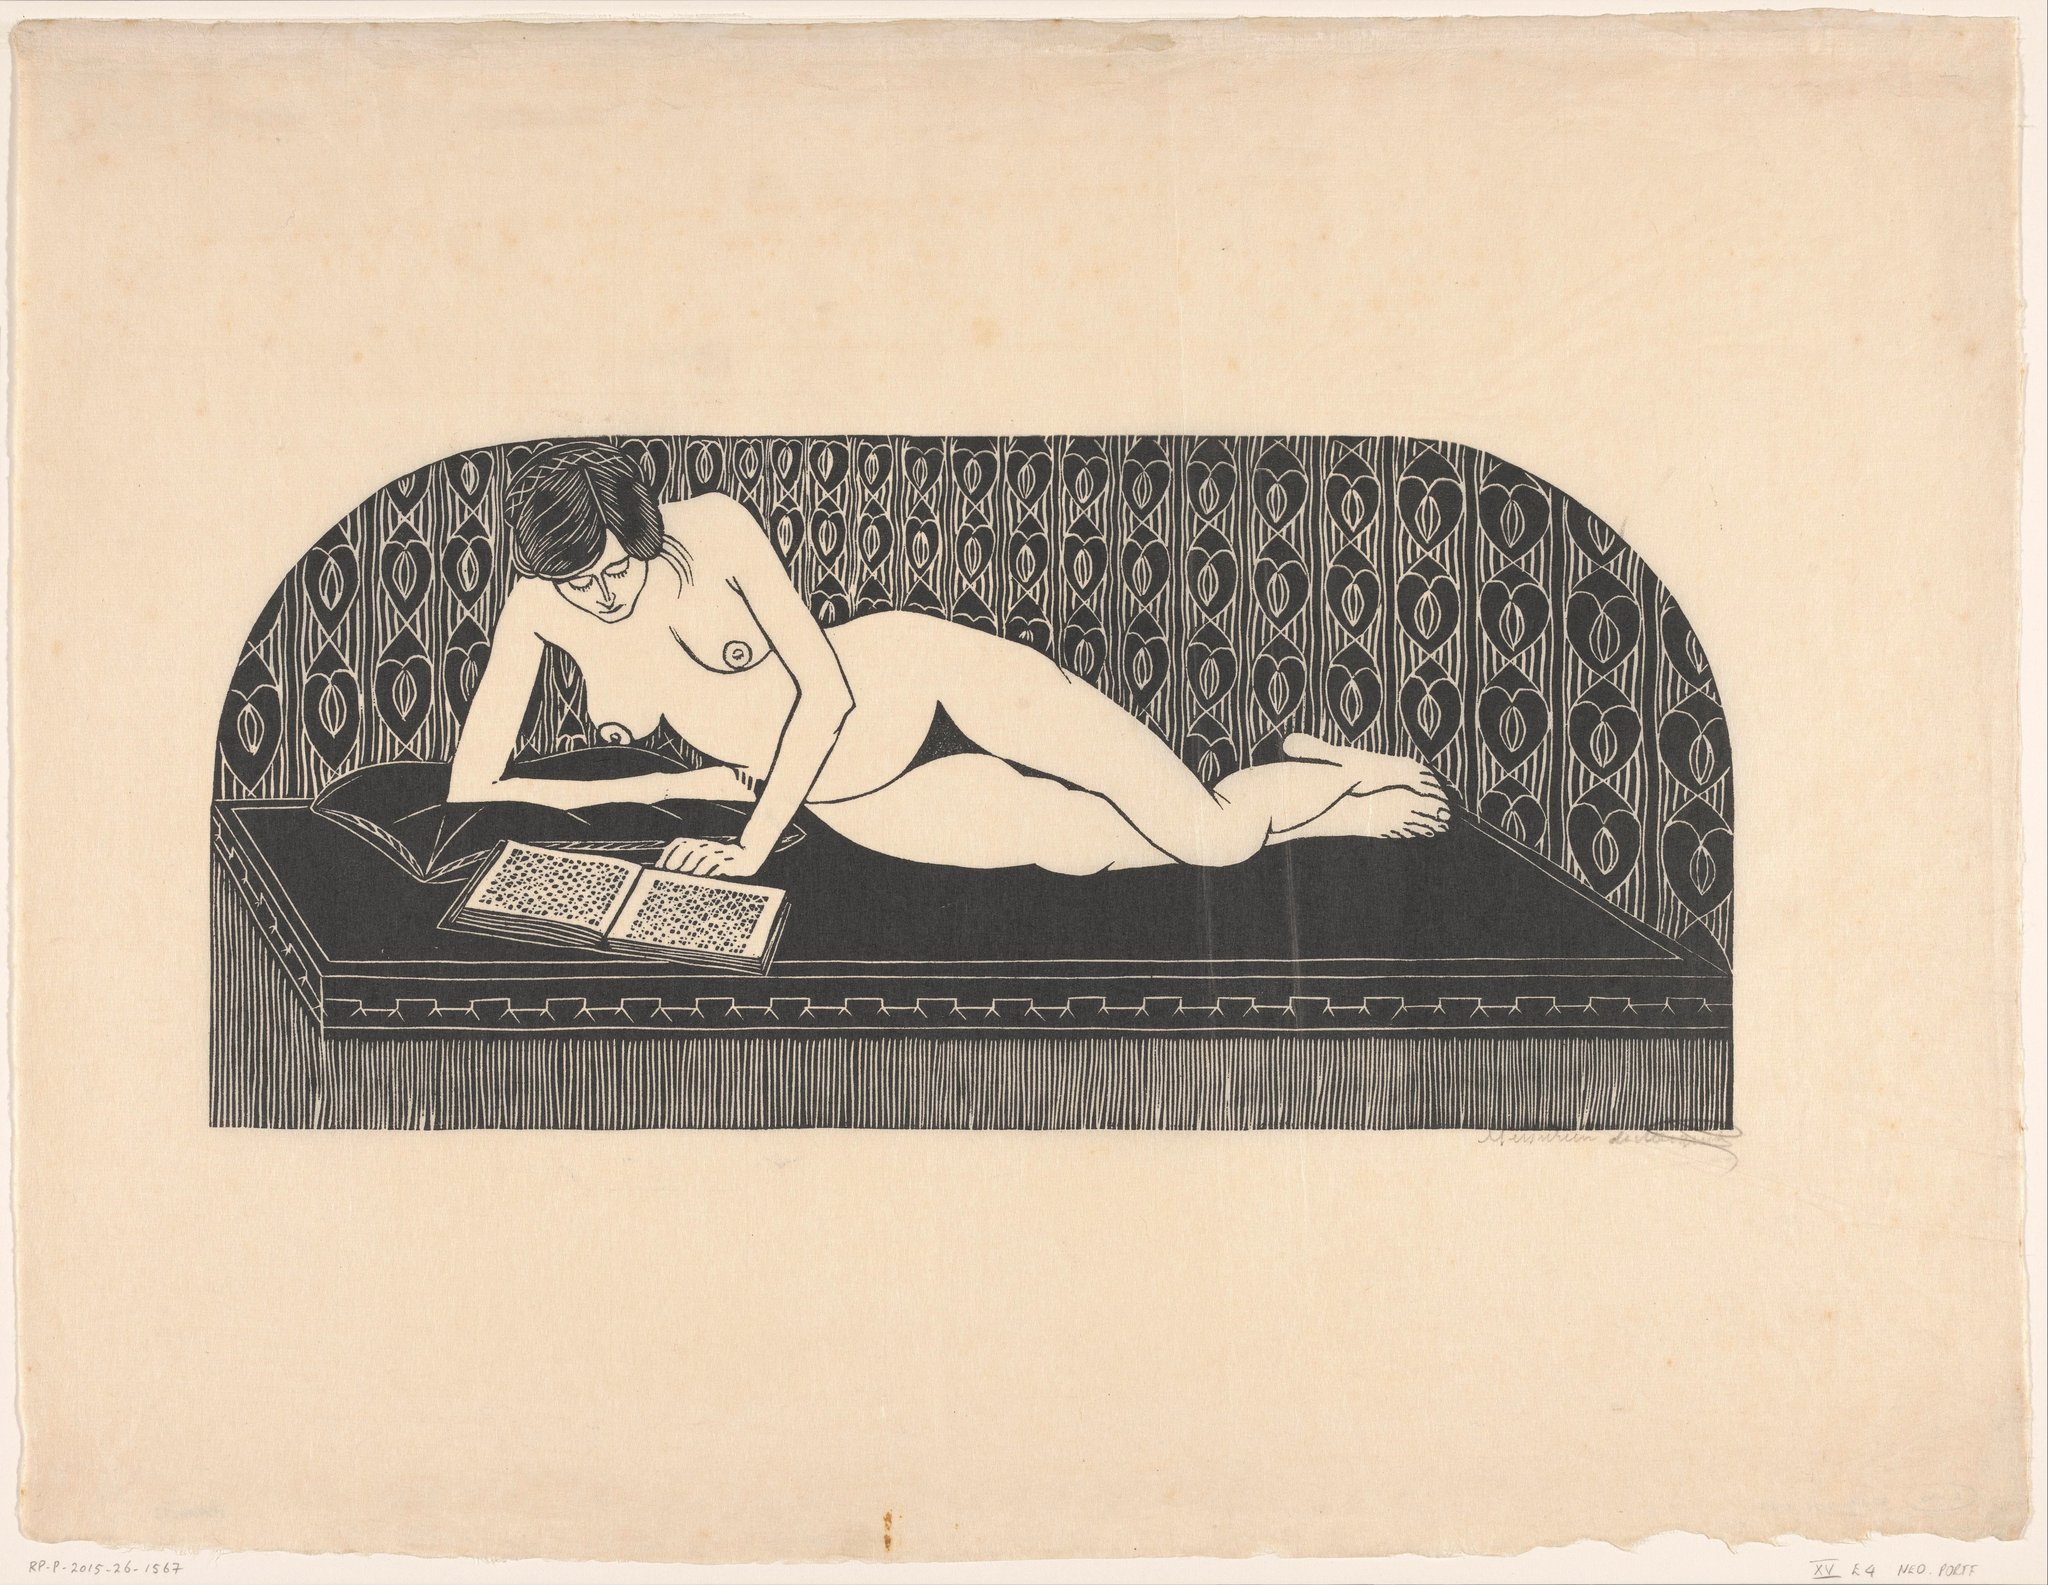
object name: print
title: Lezen (Liggend naakt, een boek lezend)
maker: samuel jessurun de mesquita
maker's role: draughtsman, print maker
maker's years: 1868-1944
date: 1913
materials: paper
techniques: woodcut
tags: reading, book, the (nude) human figure; 'corpo humano' (ripa) - aa - female human figure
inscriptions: collector's mark: Lugt 2228